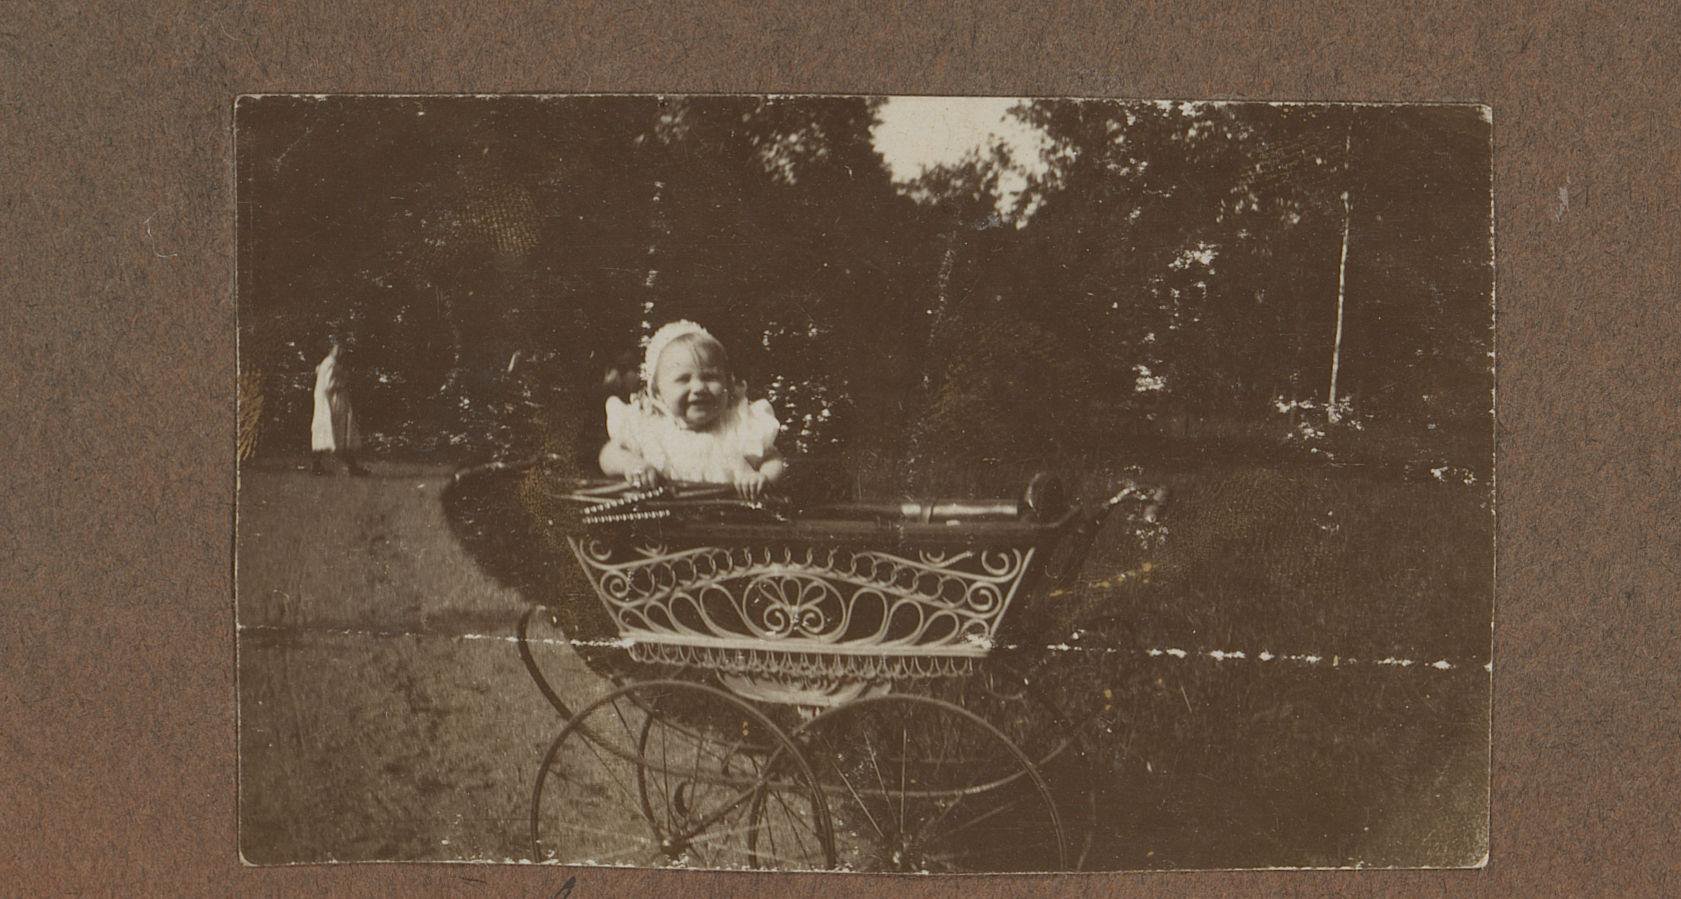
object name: photograph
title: Joanna Diepenbrock in kinderwagen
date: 1906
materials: photographic support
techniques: collodion silver print, pasting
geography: netherlands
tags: amsterdam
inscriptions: date: ‘1912.’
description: Foto op bruin albumblad 11 van familiealbum van Alphons Diepenbrock.